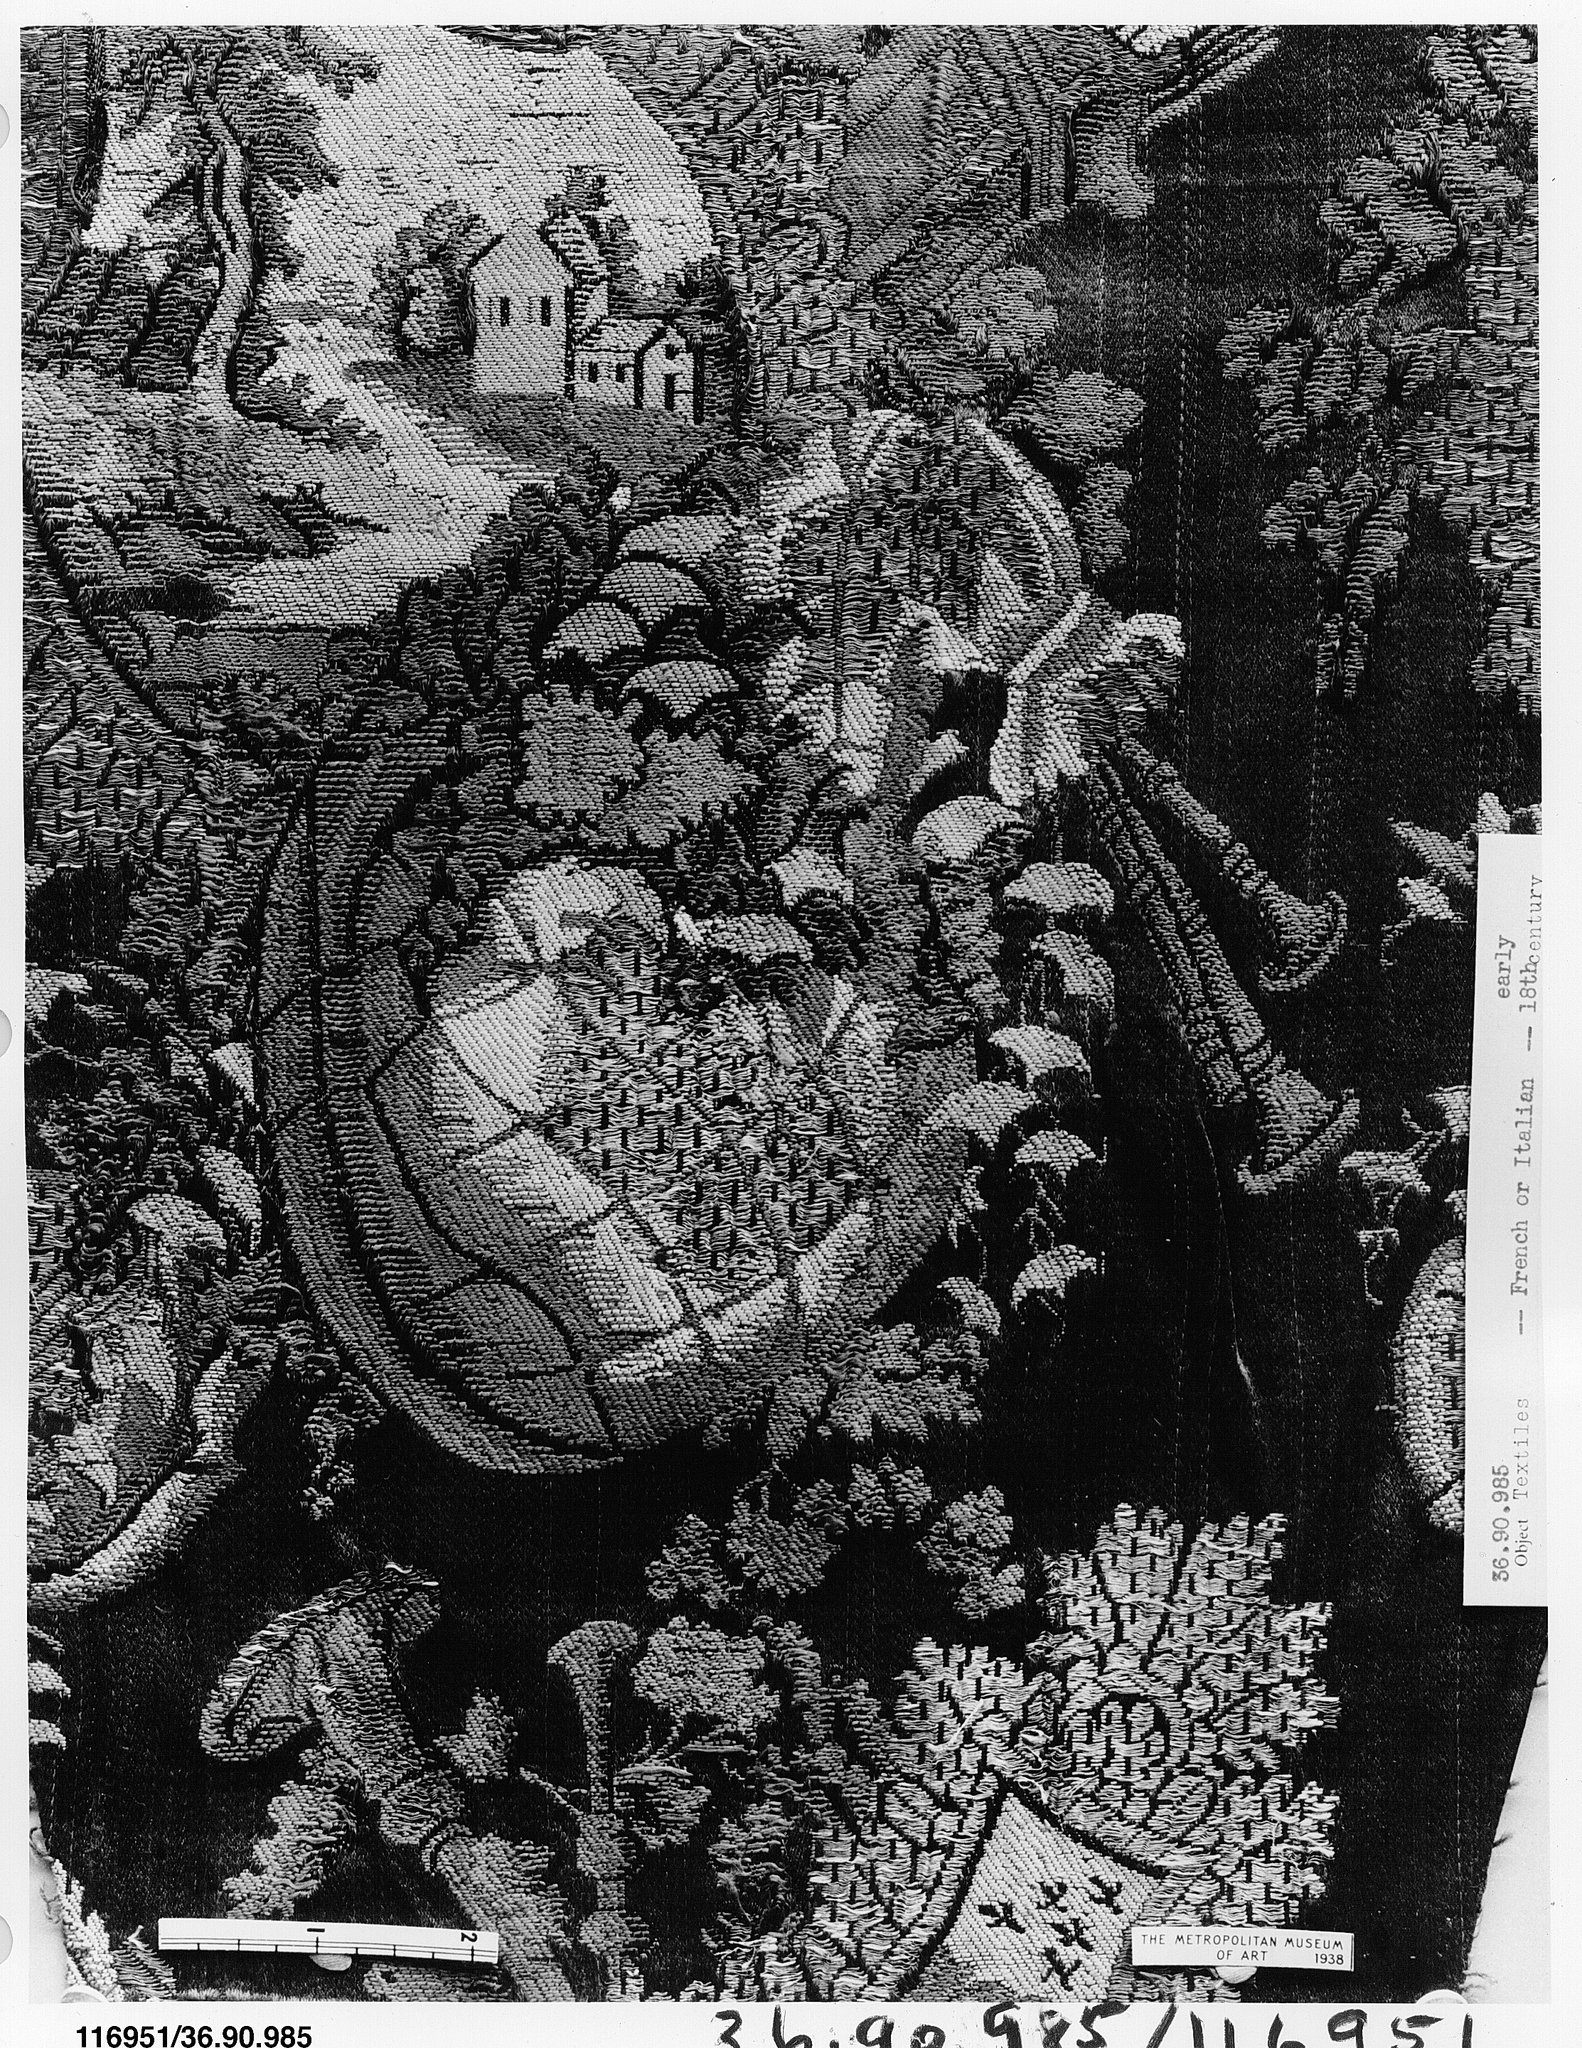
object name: piece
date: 1735-1740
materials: metal thread, silk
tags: houses,horns,flowers